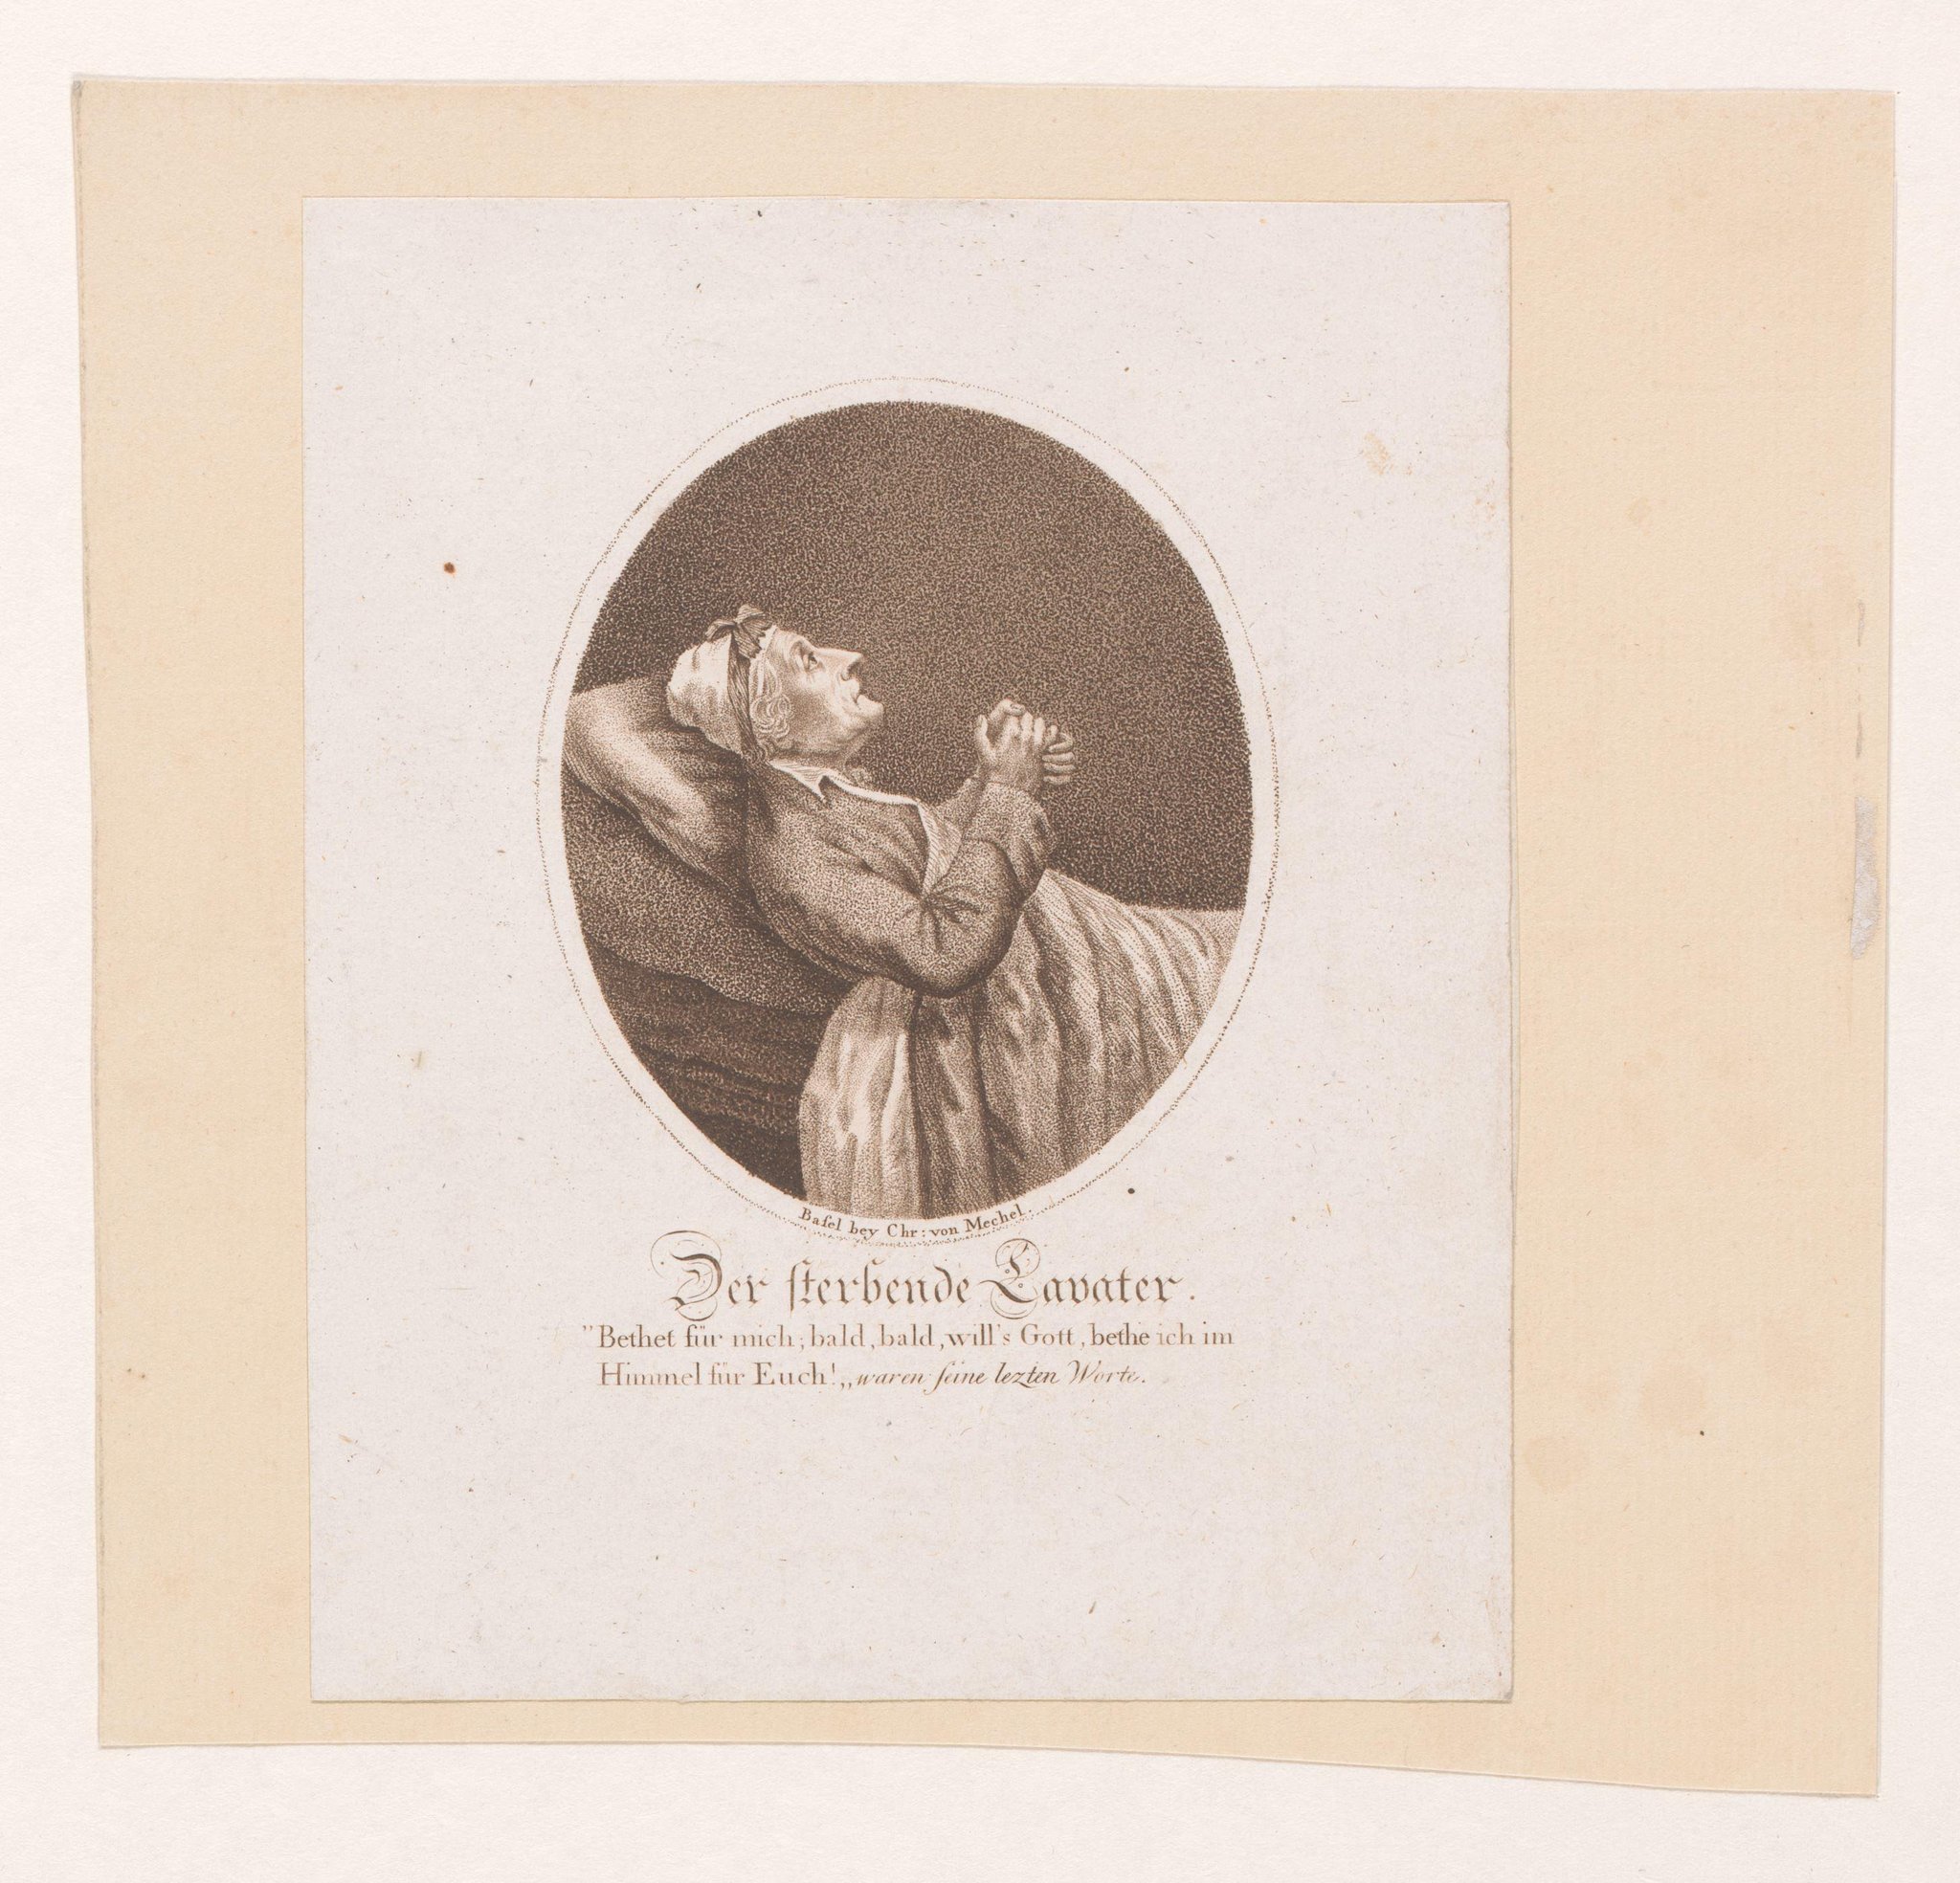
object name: print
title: Portret van Johann Kaspar Lavater op zijn sterfbed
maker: christian von mechel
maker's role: draughtsman, print maker, publisher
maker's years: 1737-1817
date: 1801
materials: paper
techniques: aquatint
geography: basel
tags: johann caspar lavater, deathbed, portrait of a writer